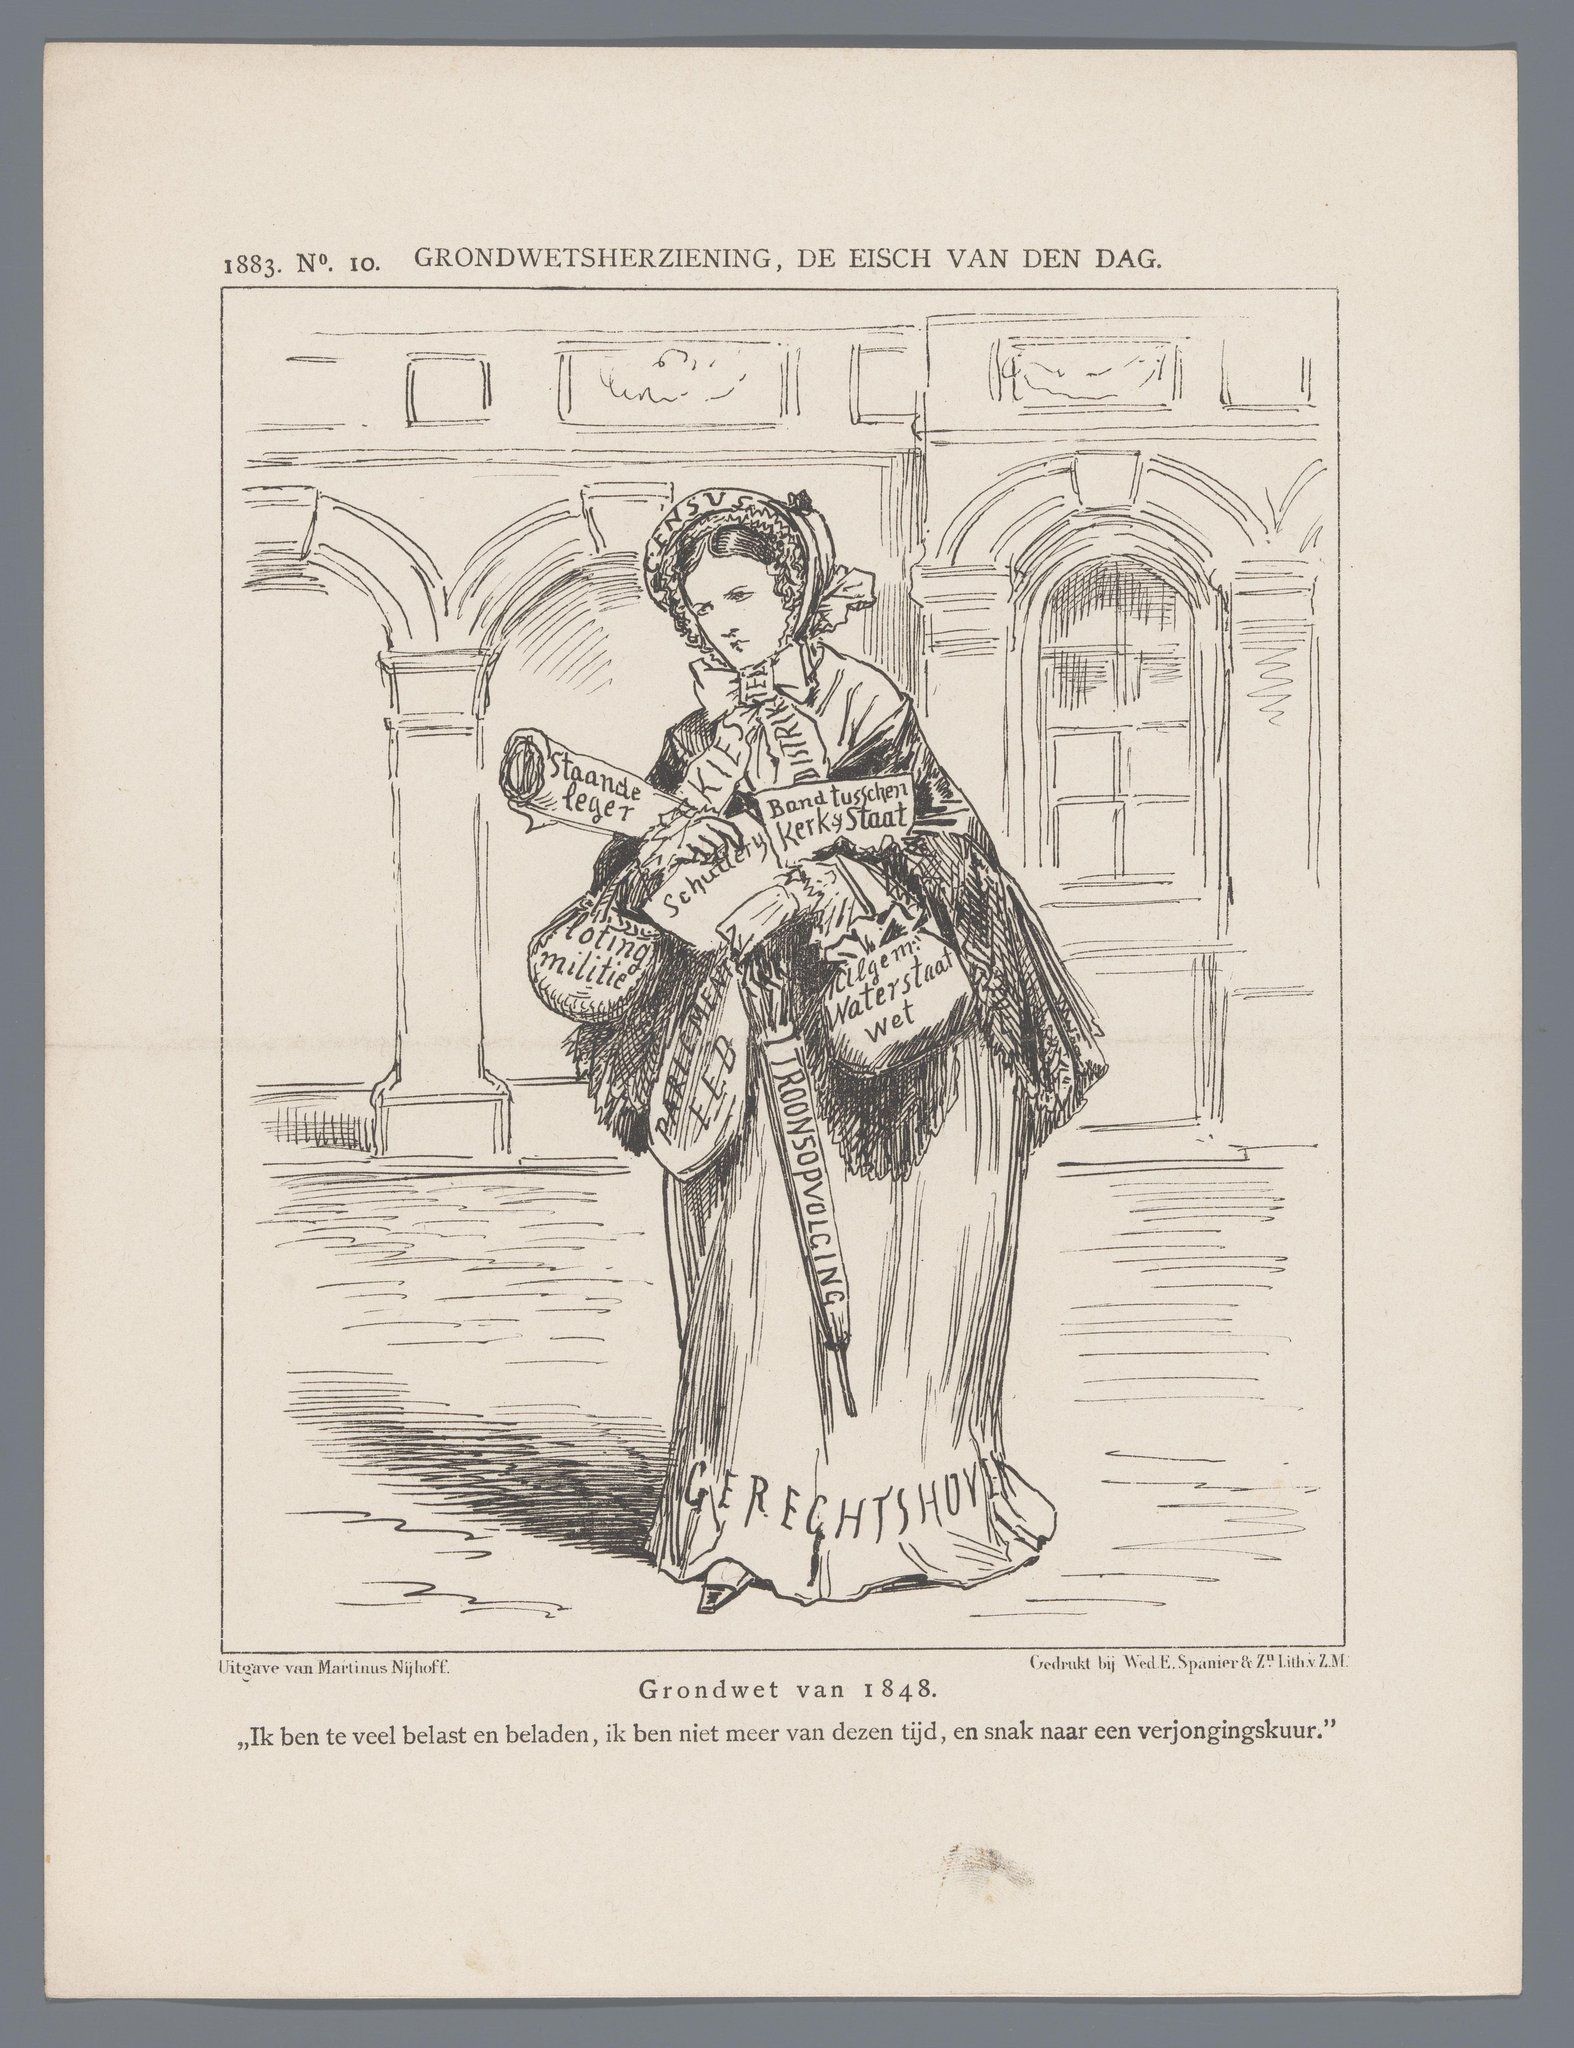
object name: print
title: Politieke spotprent over de noodzaak tot herziening van de grondwet, 1883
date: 1883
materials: paper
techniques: lithograph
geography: netherlands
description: Politieke spotprent over de noodzaak tot herziening van de grondwet van 1848. Plaat verschenen bij het weekblad De Nederlandsche Spectator, nr. 10, 1883.